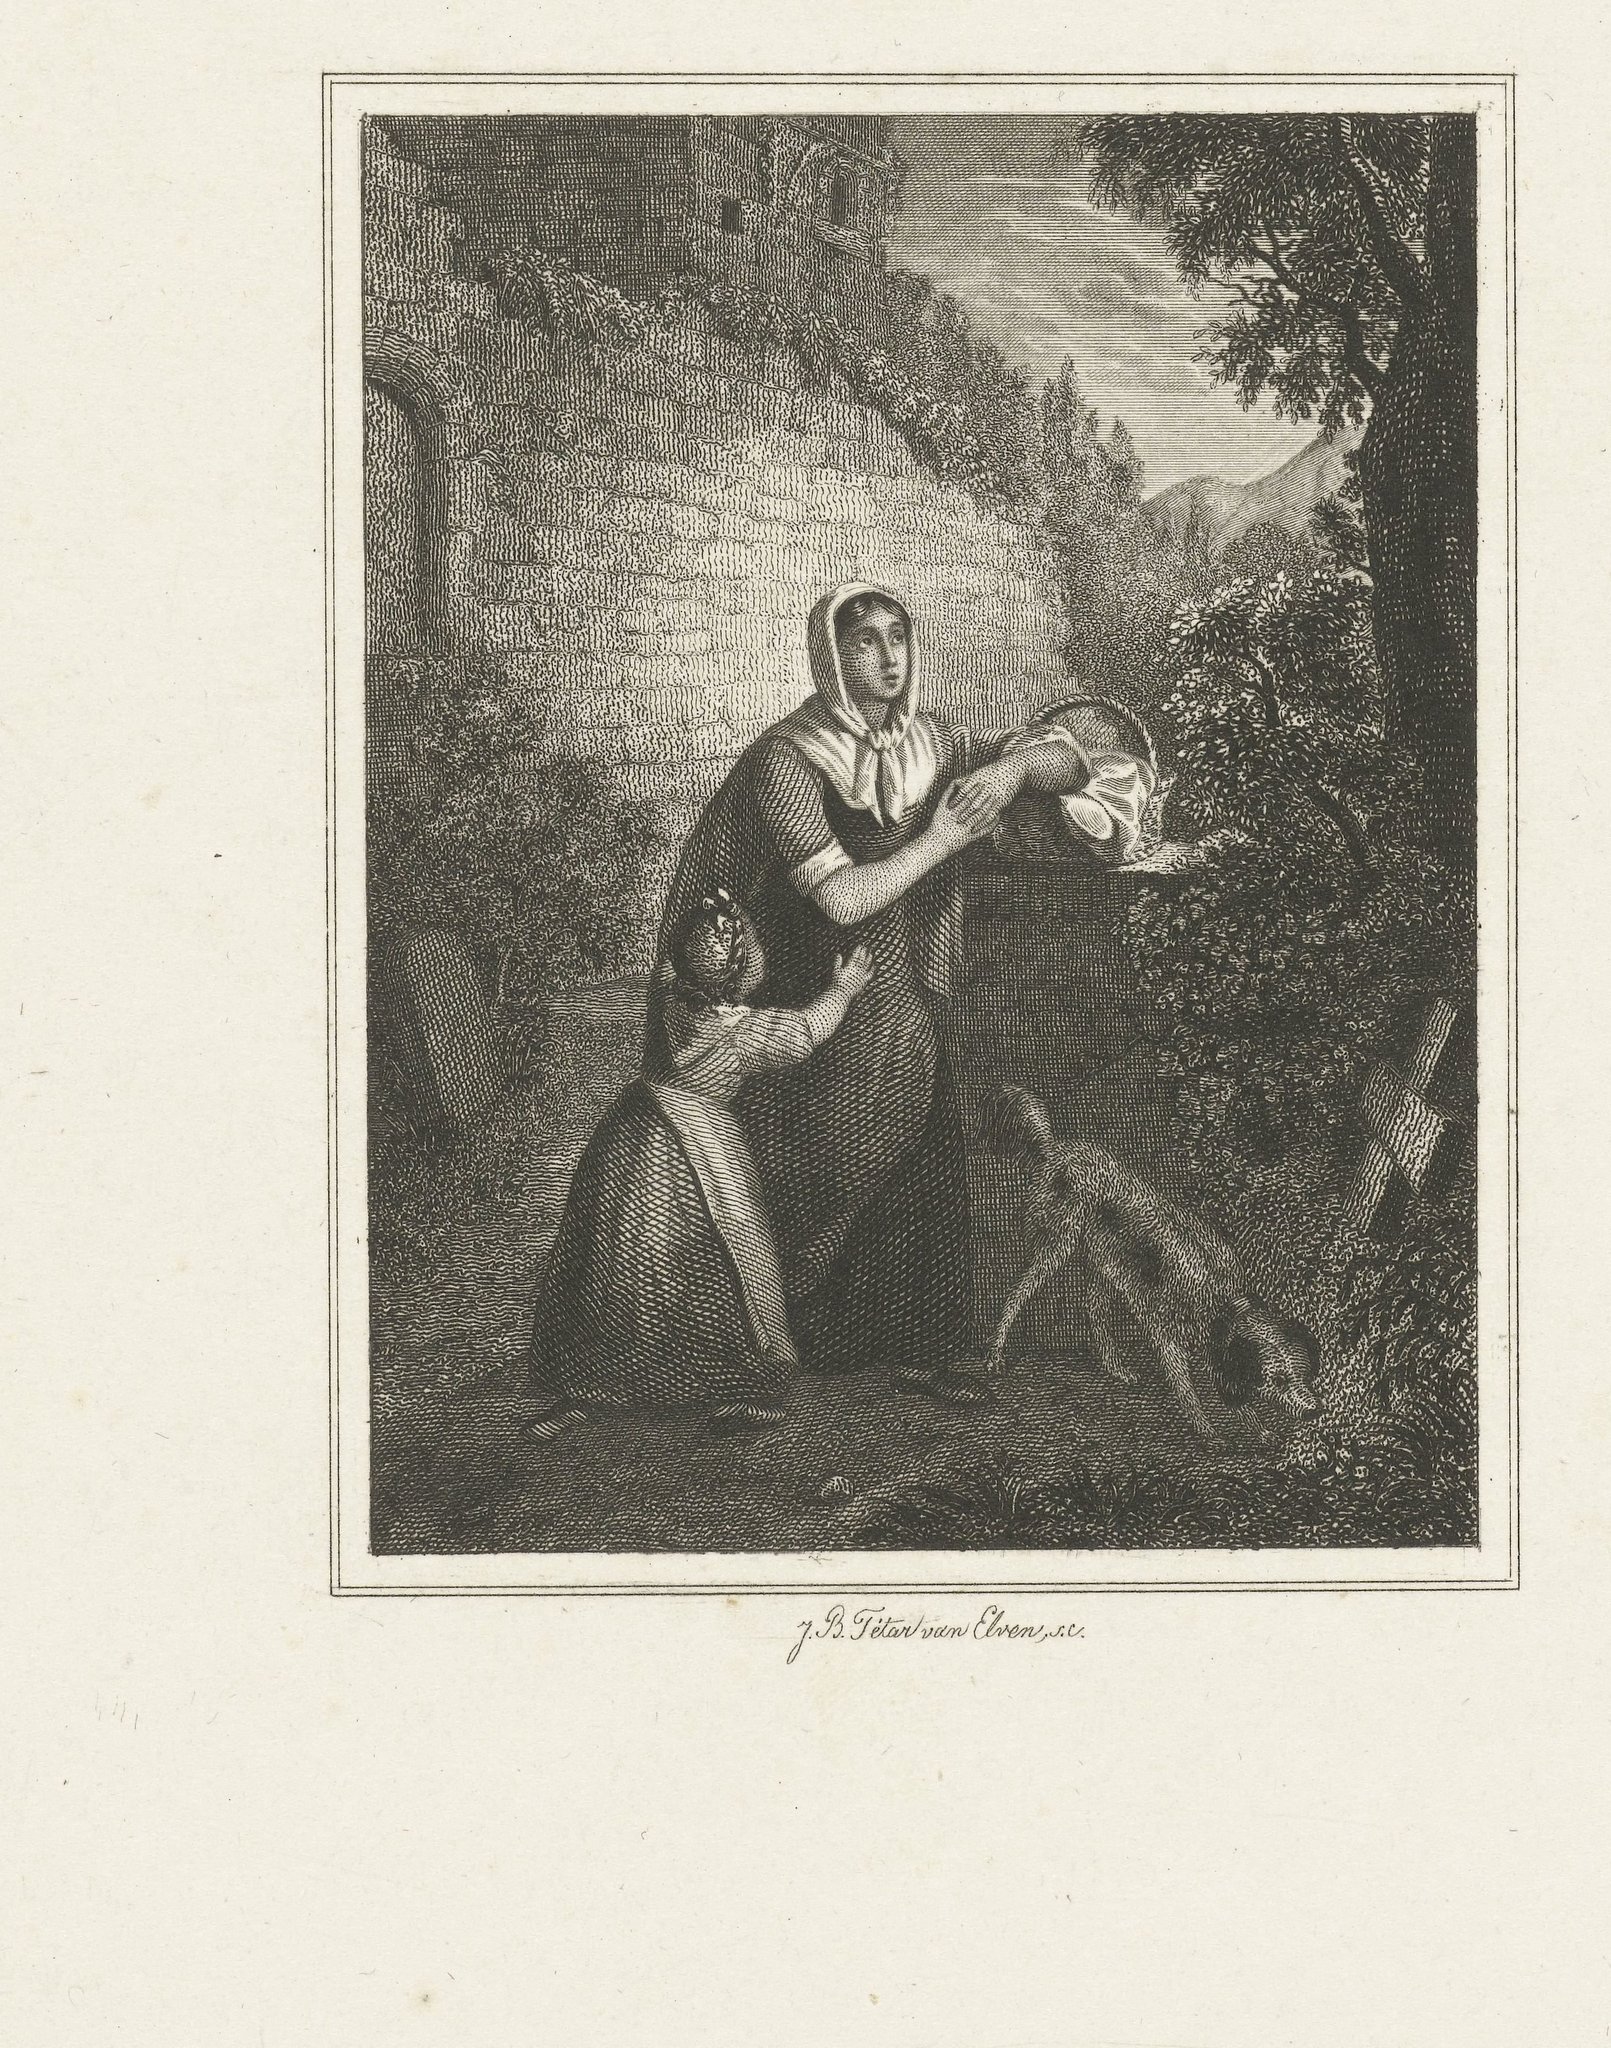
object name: print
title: Biddende vrouw op kerkhof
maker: jan baptist tetar van elven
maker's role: draughtsman, print maker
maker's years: 1805-1889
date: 1815-1889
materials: paper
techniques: engraving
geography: netherlands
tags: one person praying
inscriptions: collector's mark: Lugt 2228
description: Op een kerkhof kijkt een vrouw met de handen ineen geslagen omhoog. Om haar arm heeft ze een mand en naast haar staat een kind. Bij een grafzerk op de voorgrond snuffelt een hond.